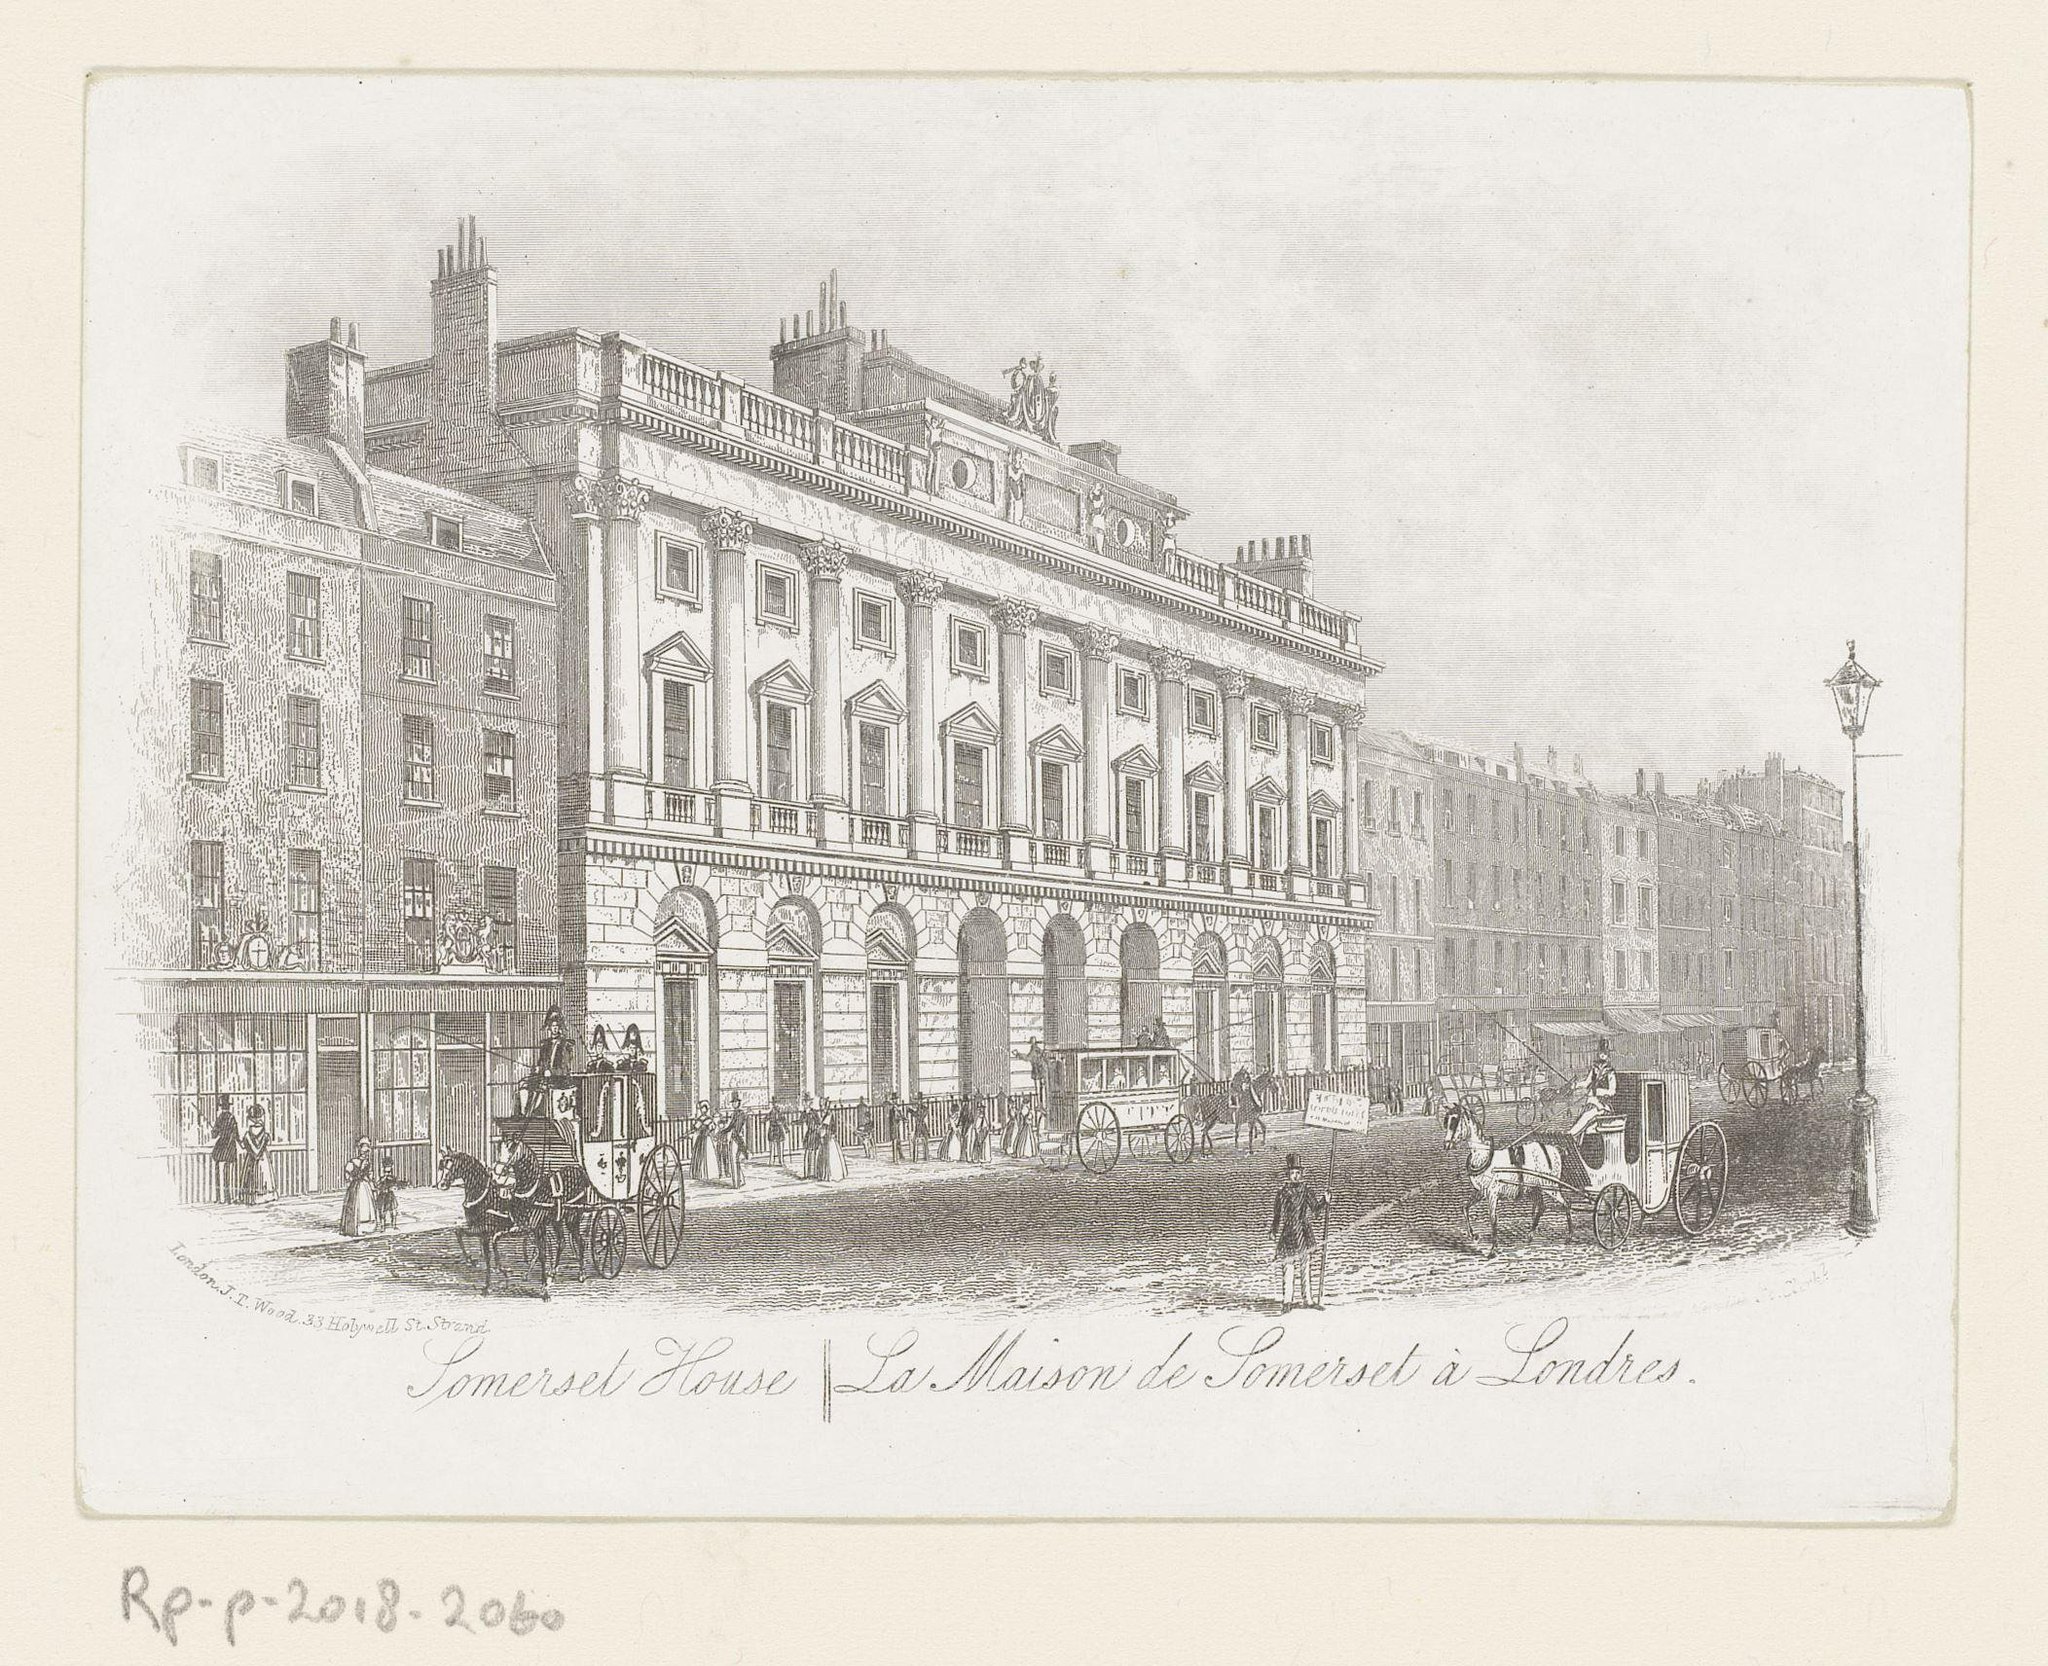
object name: print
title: Somerset House / La Maison de Somerset à Londres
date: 1841-1885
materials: paper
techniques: etching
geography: london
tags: university building, college